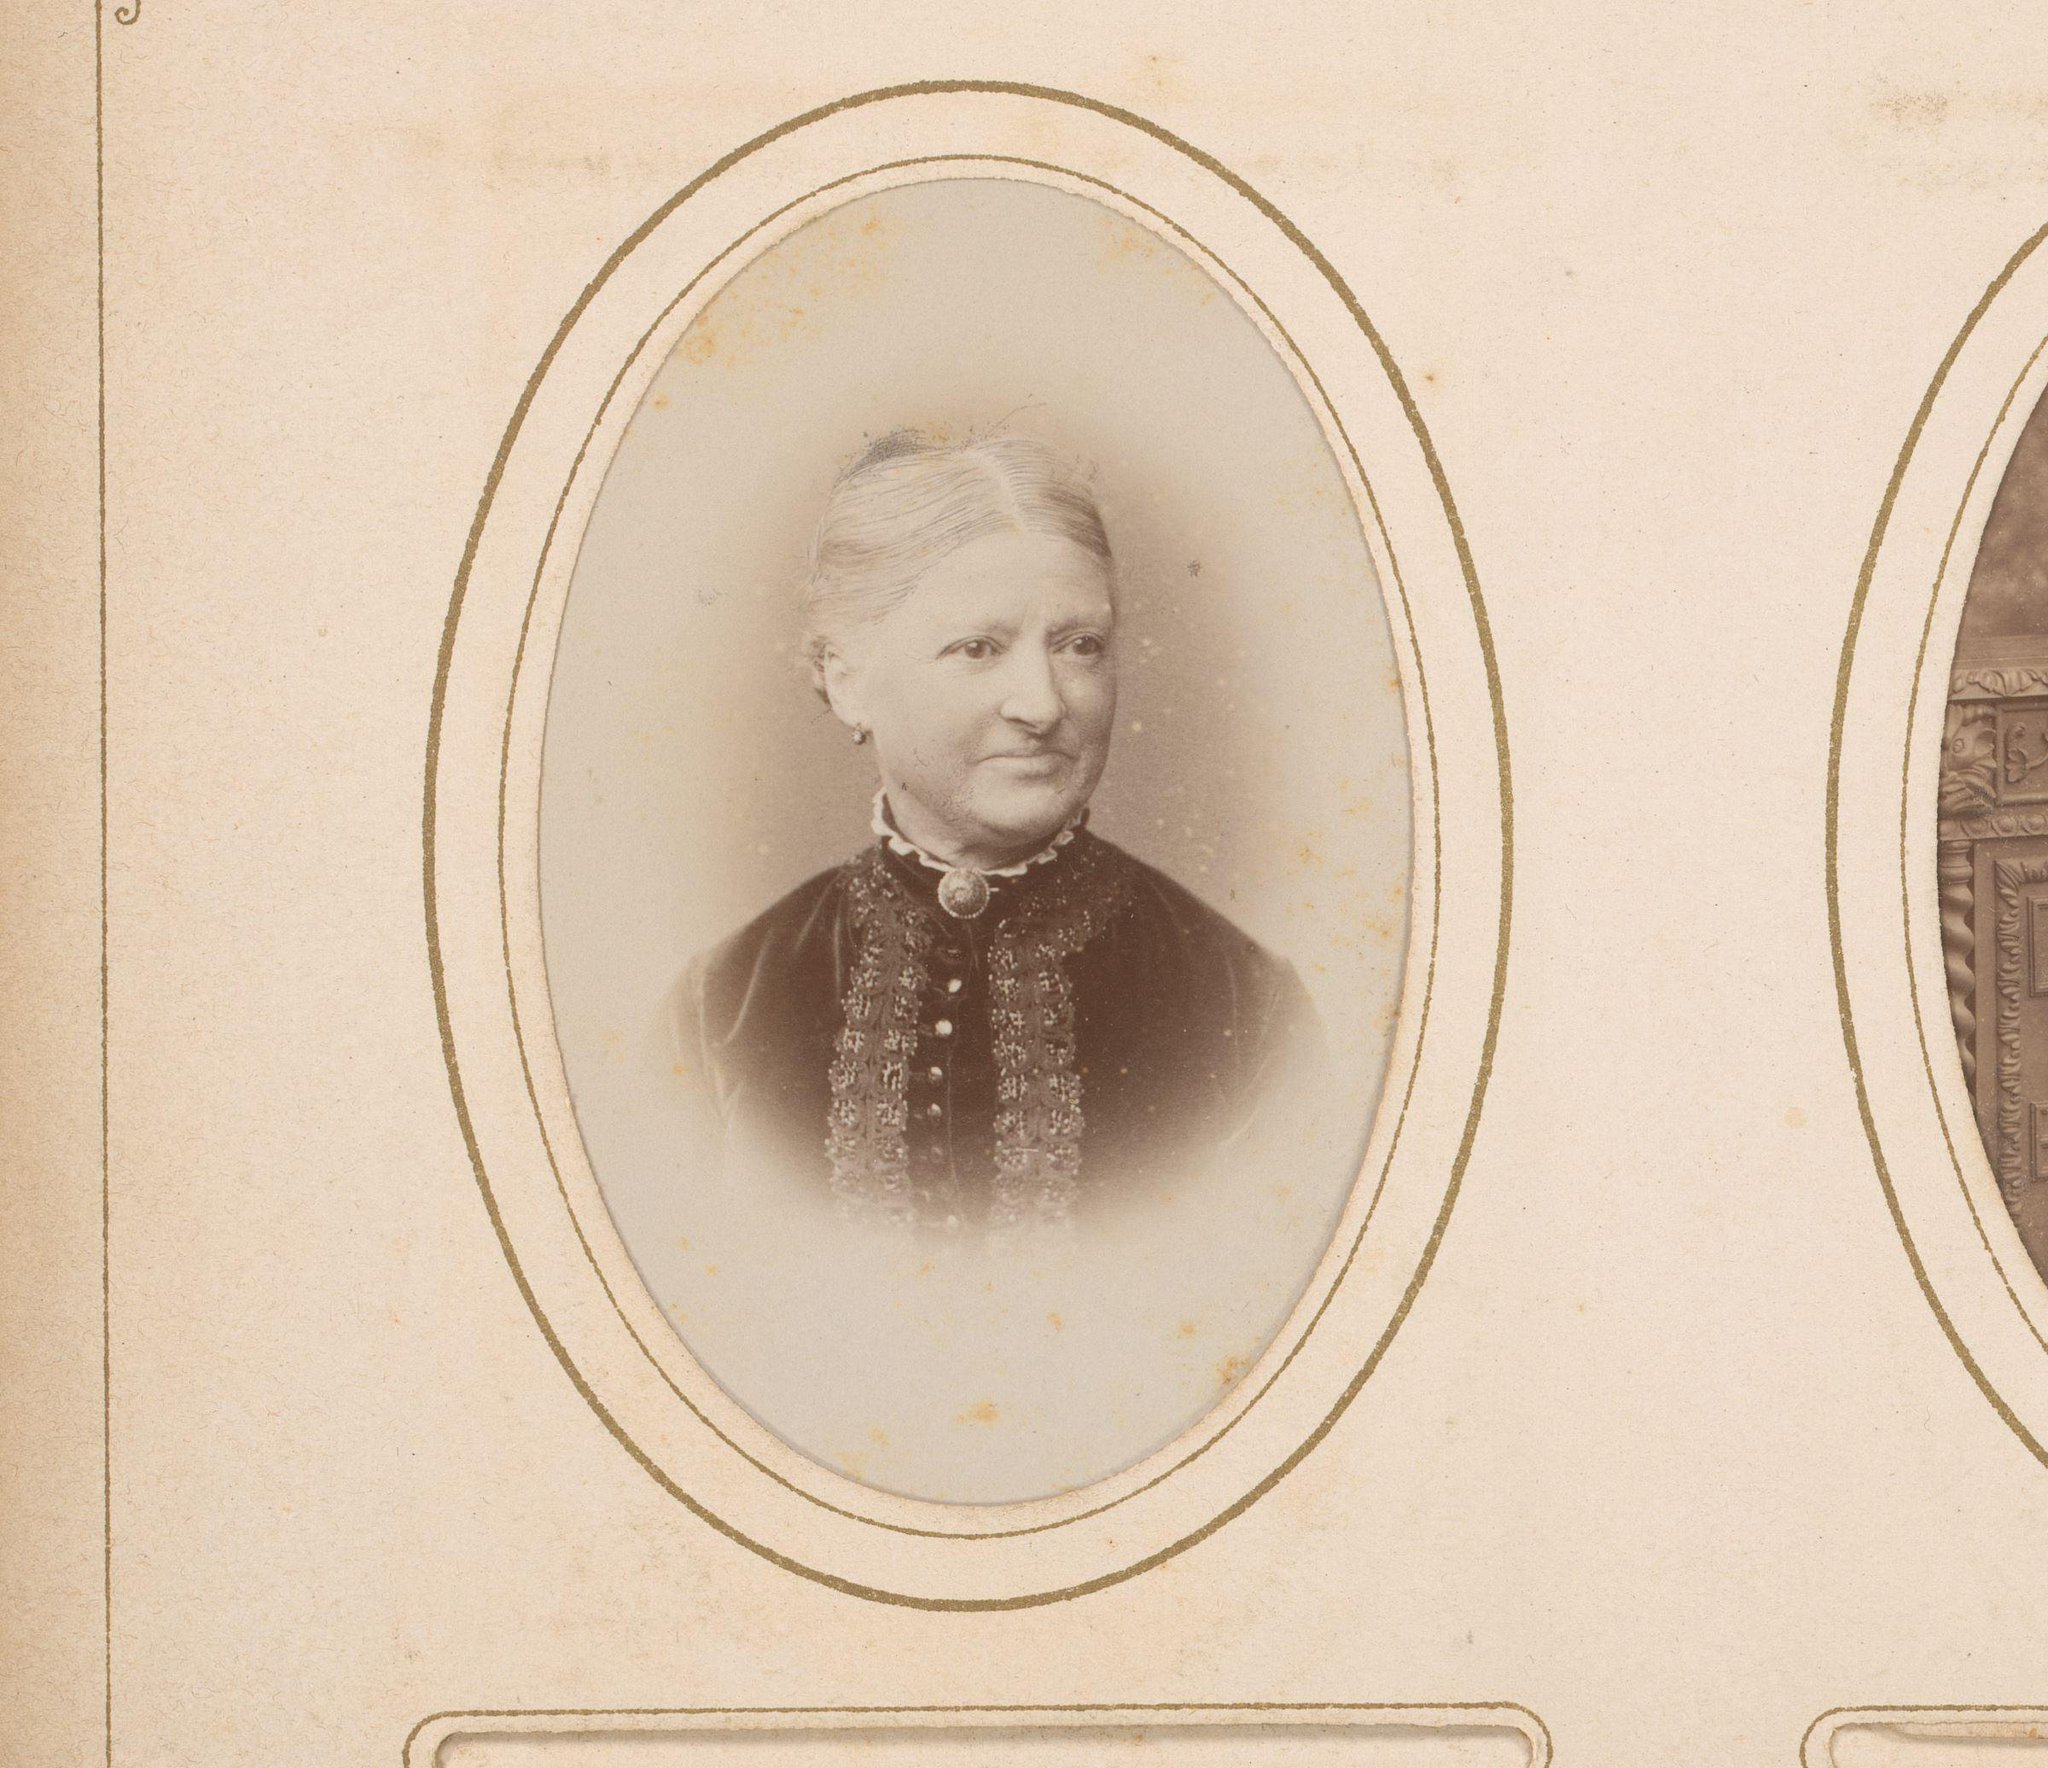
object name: photograph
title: Portret van een vrouw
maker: carel eduard westerborg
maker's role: fotograaf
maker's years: 1842-1916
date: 1861-1900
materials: cardboard, photographic support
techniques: albumen print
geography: arnhem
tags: historical persons - bb - woman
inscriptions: inscription: ‘C. E. WESTERBORG/ Photograaf/ Eus: Buiten Singel 1./ Arnhem/ Voor nabestelling worden alle/ negatieven bewaard.’